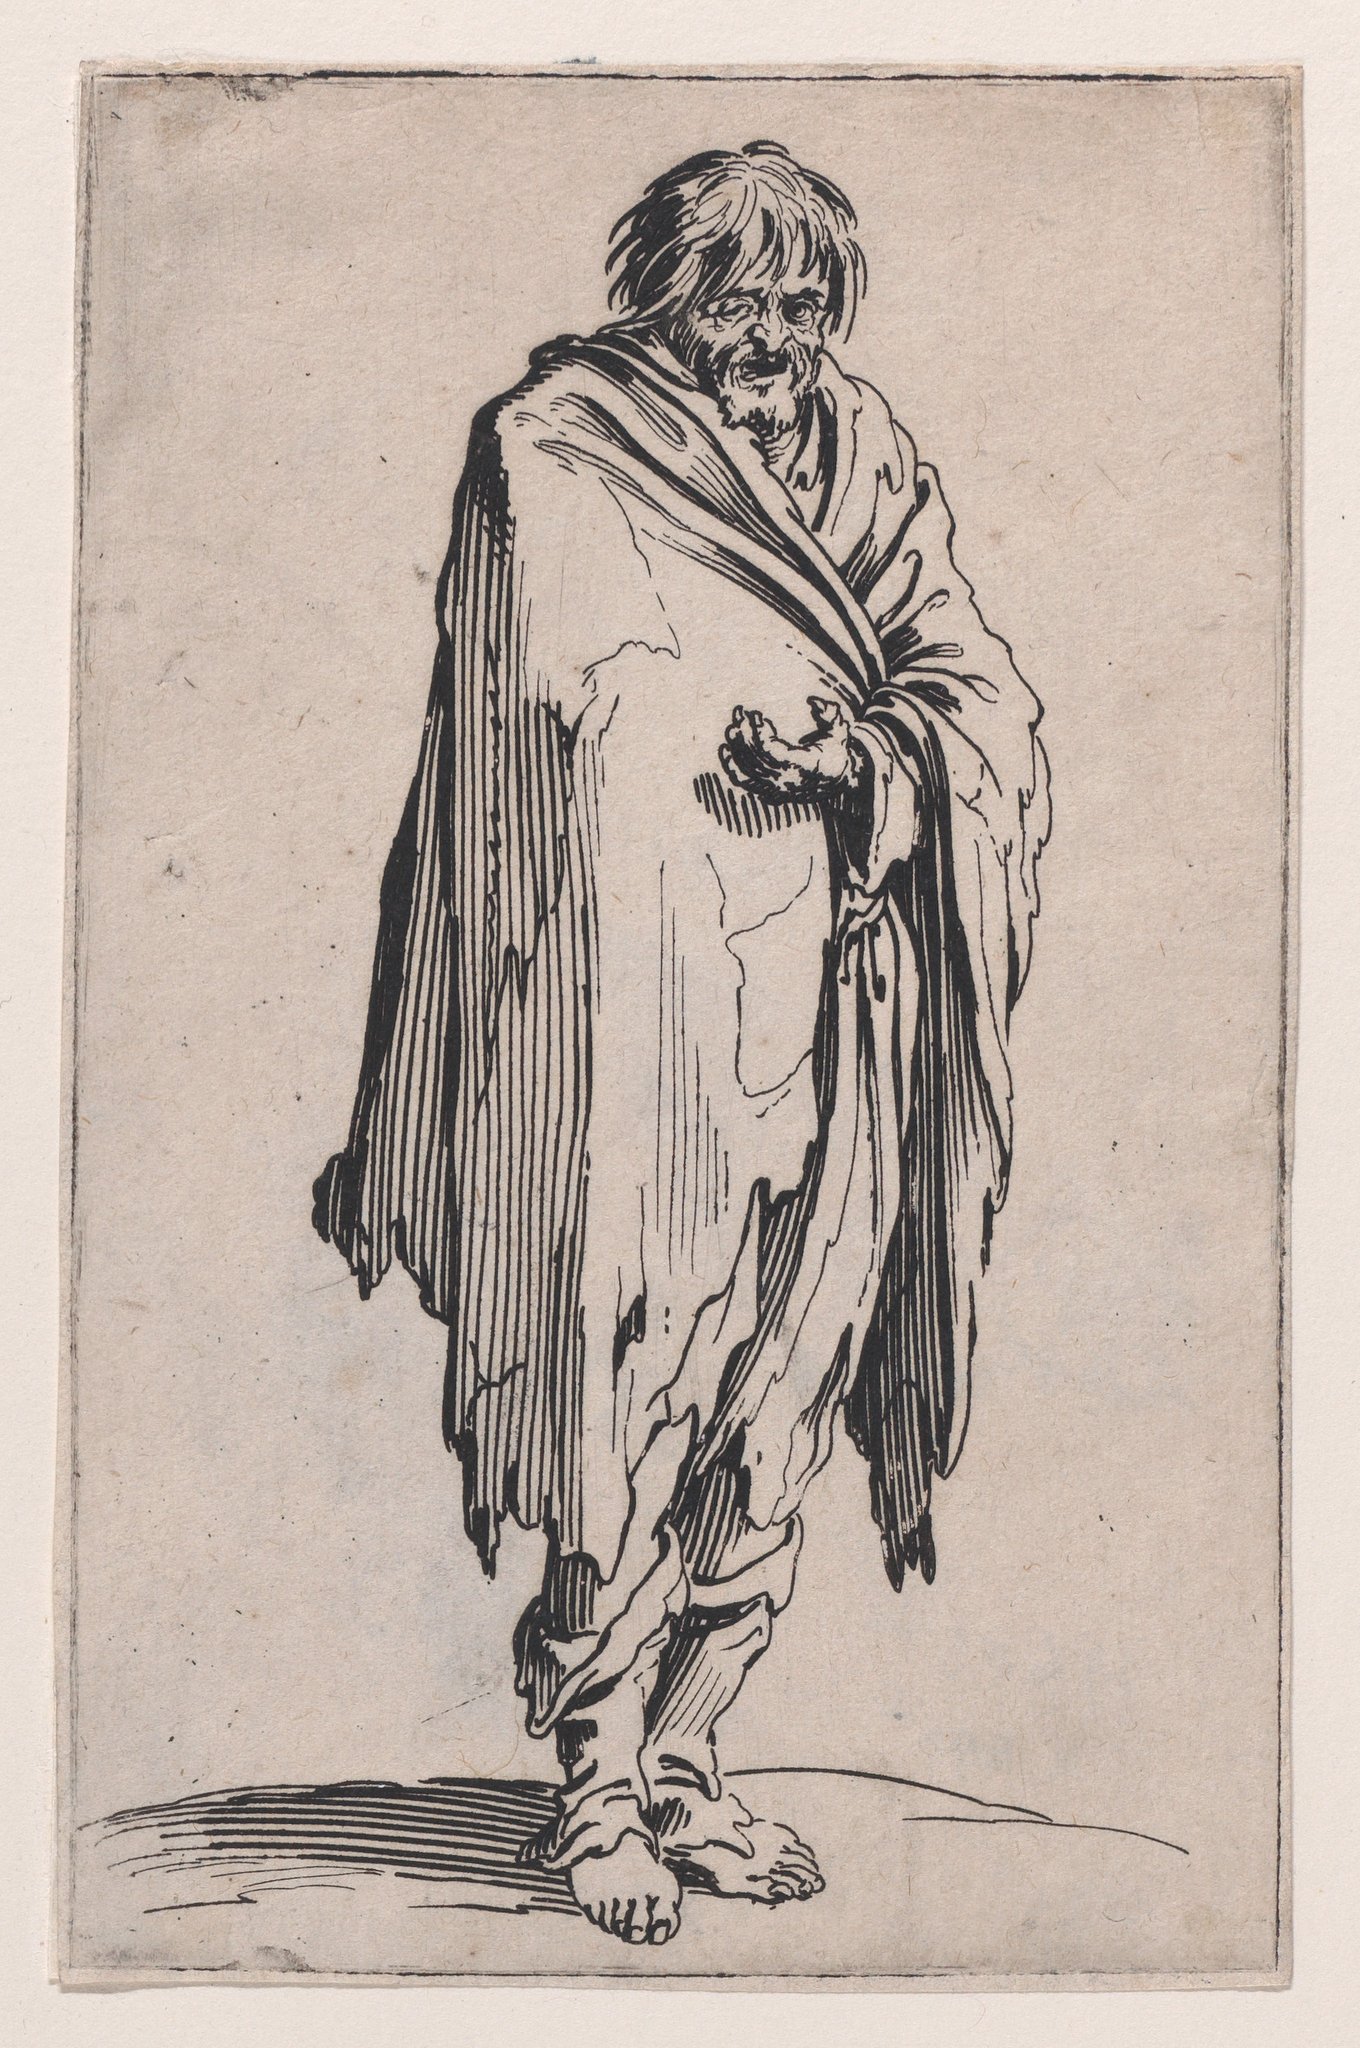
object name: print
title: Le Mendiant a la Tête Découverte et aux Pieds Nuds (The Beggar with the Uncovered Head and Bare Feet), from "Les Gueux suite appelée aussi Les Mendiants, Les Baroni, ou Les Barons" (The Beggars, also called the Barons)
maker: jacques callot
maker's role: artist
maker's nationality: french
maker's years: 1592-1635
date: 1623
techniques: etching